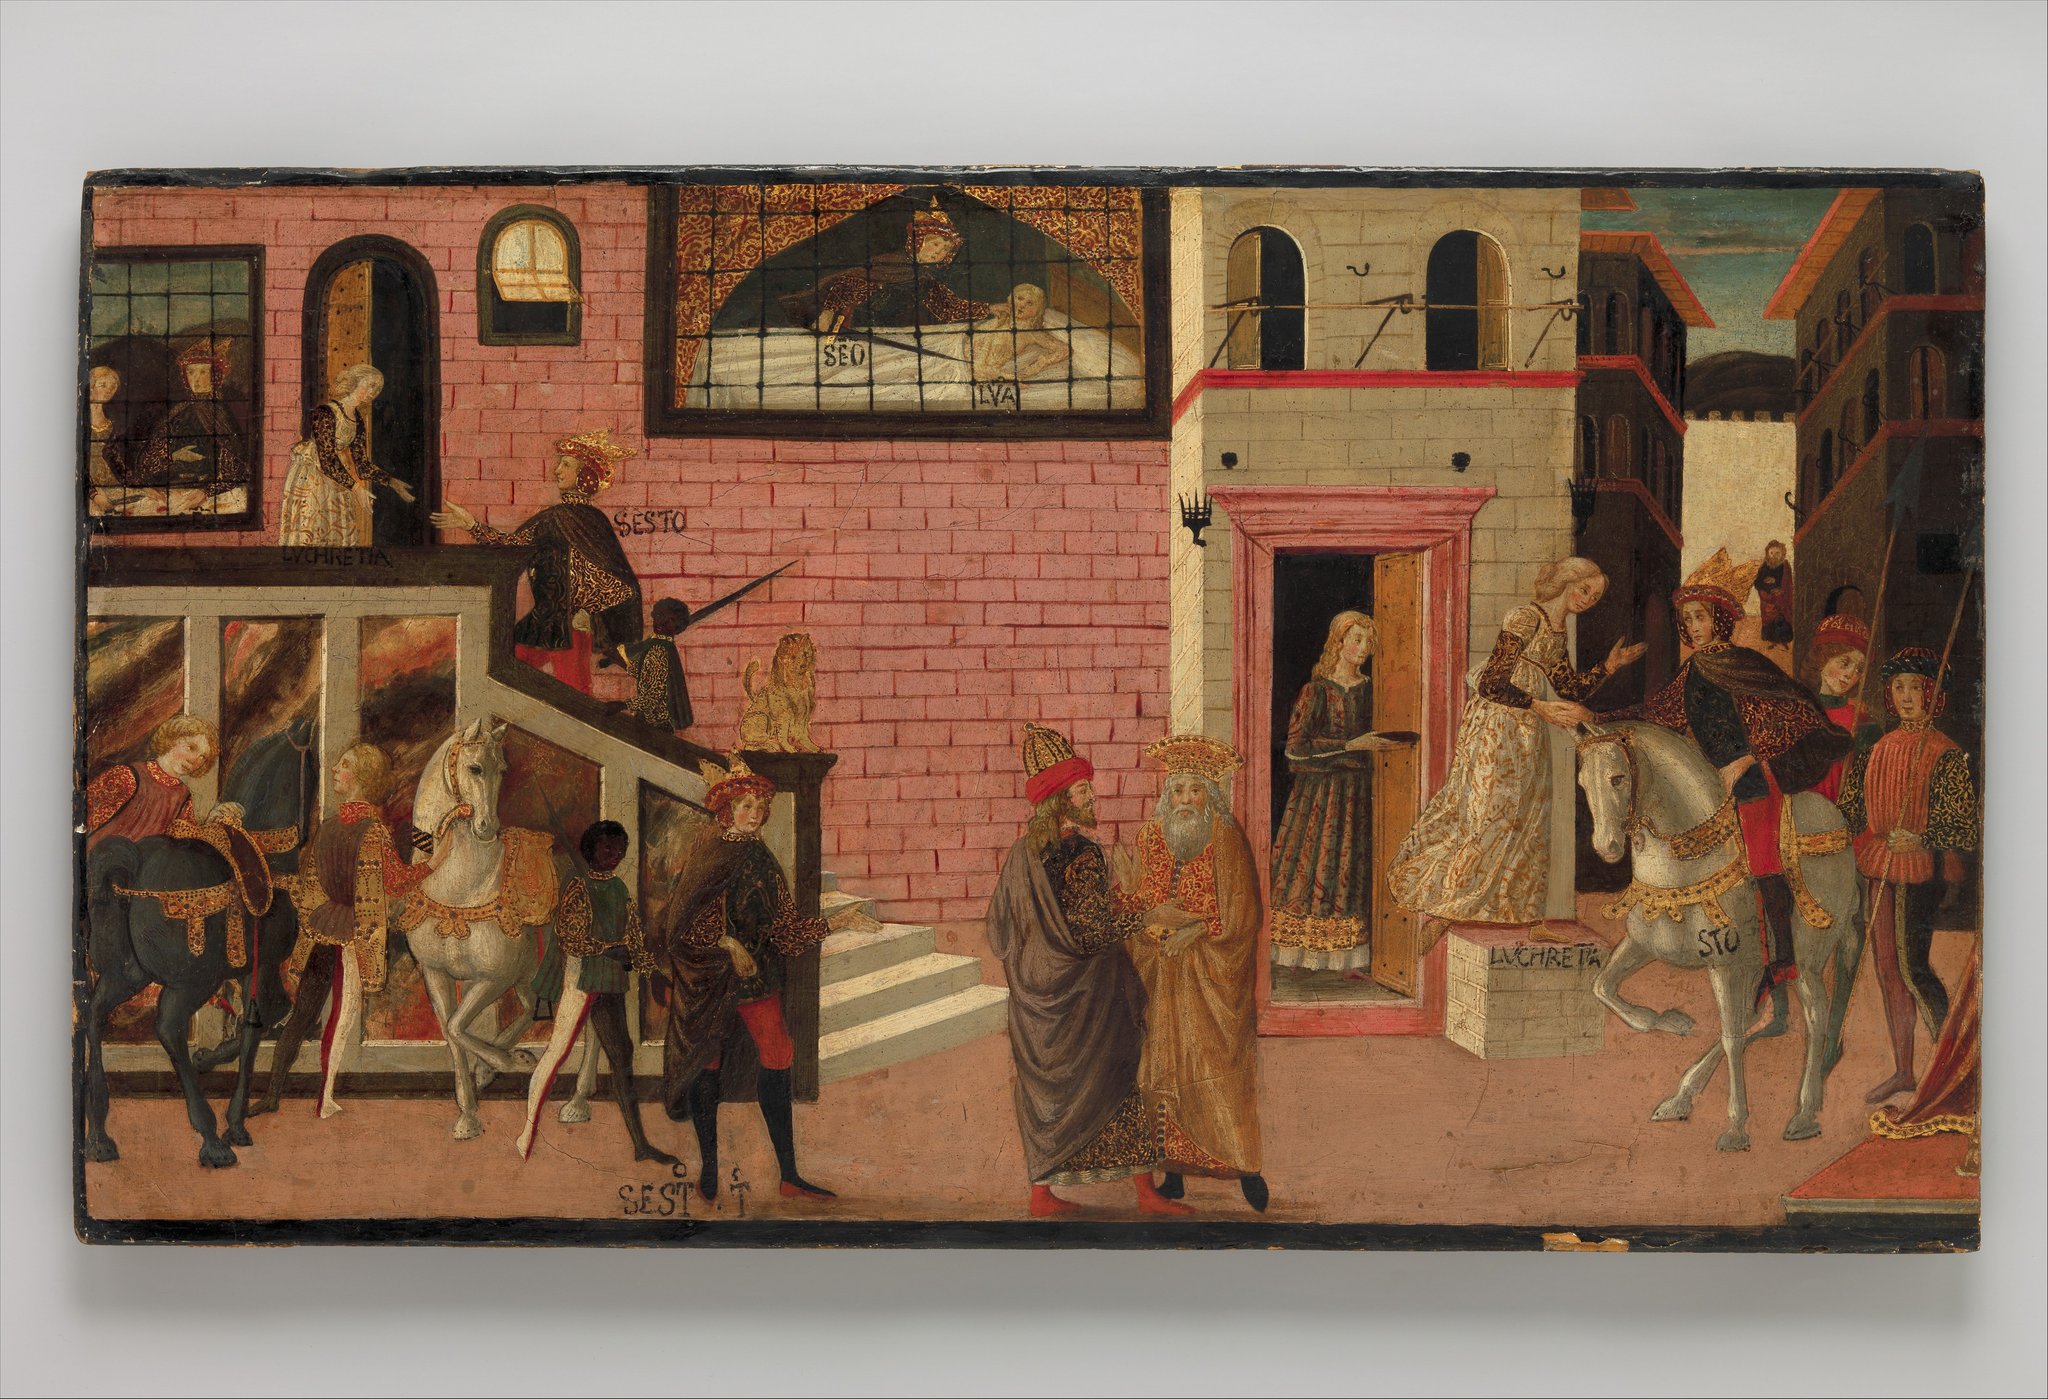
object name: painting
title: The Rape of Lucretia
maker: master of marradi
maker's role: artist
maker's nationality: italian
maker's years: 1475-1525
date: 1467-1533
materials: gold, paint, wood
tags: men,women,horses